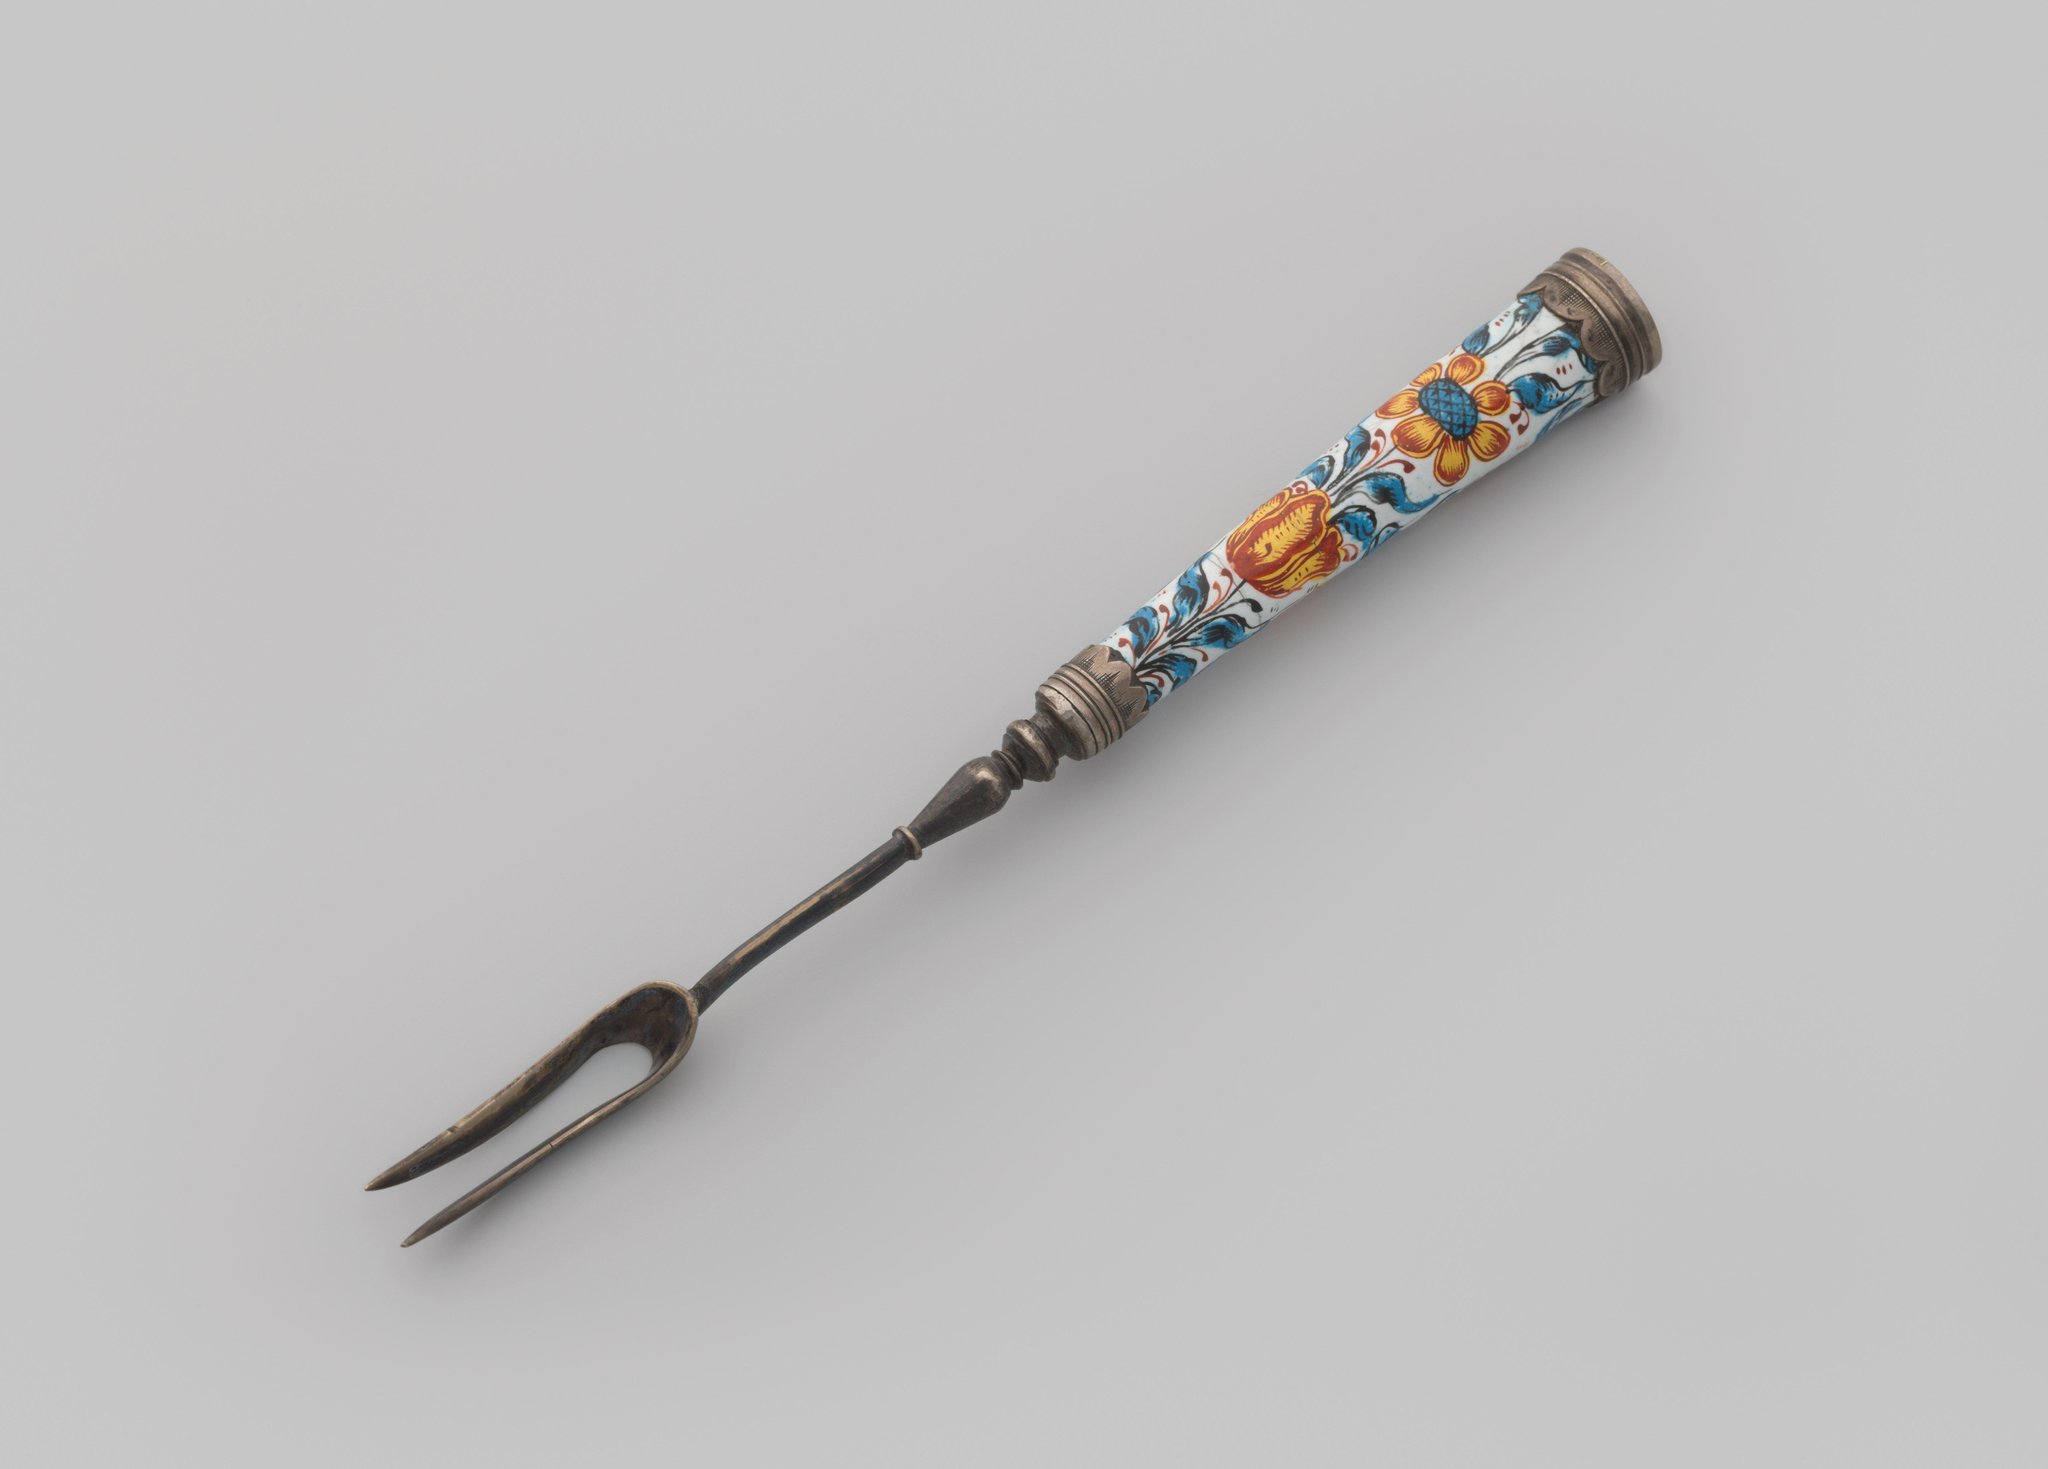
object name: fork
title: Vork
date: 1600-1699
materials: enamel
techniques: enamel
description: Vork met een geemailleerd heft. Het heft is versierd met blauwe en oranje bloemen op een witte achtergrond.